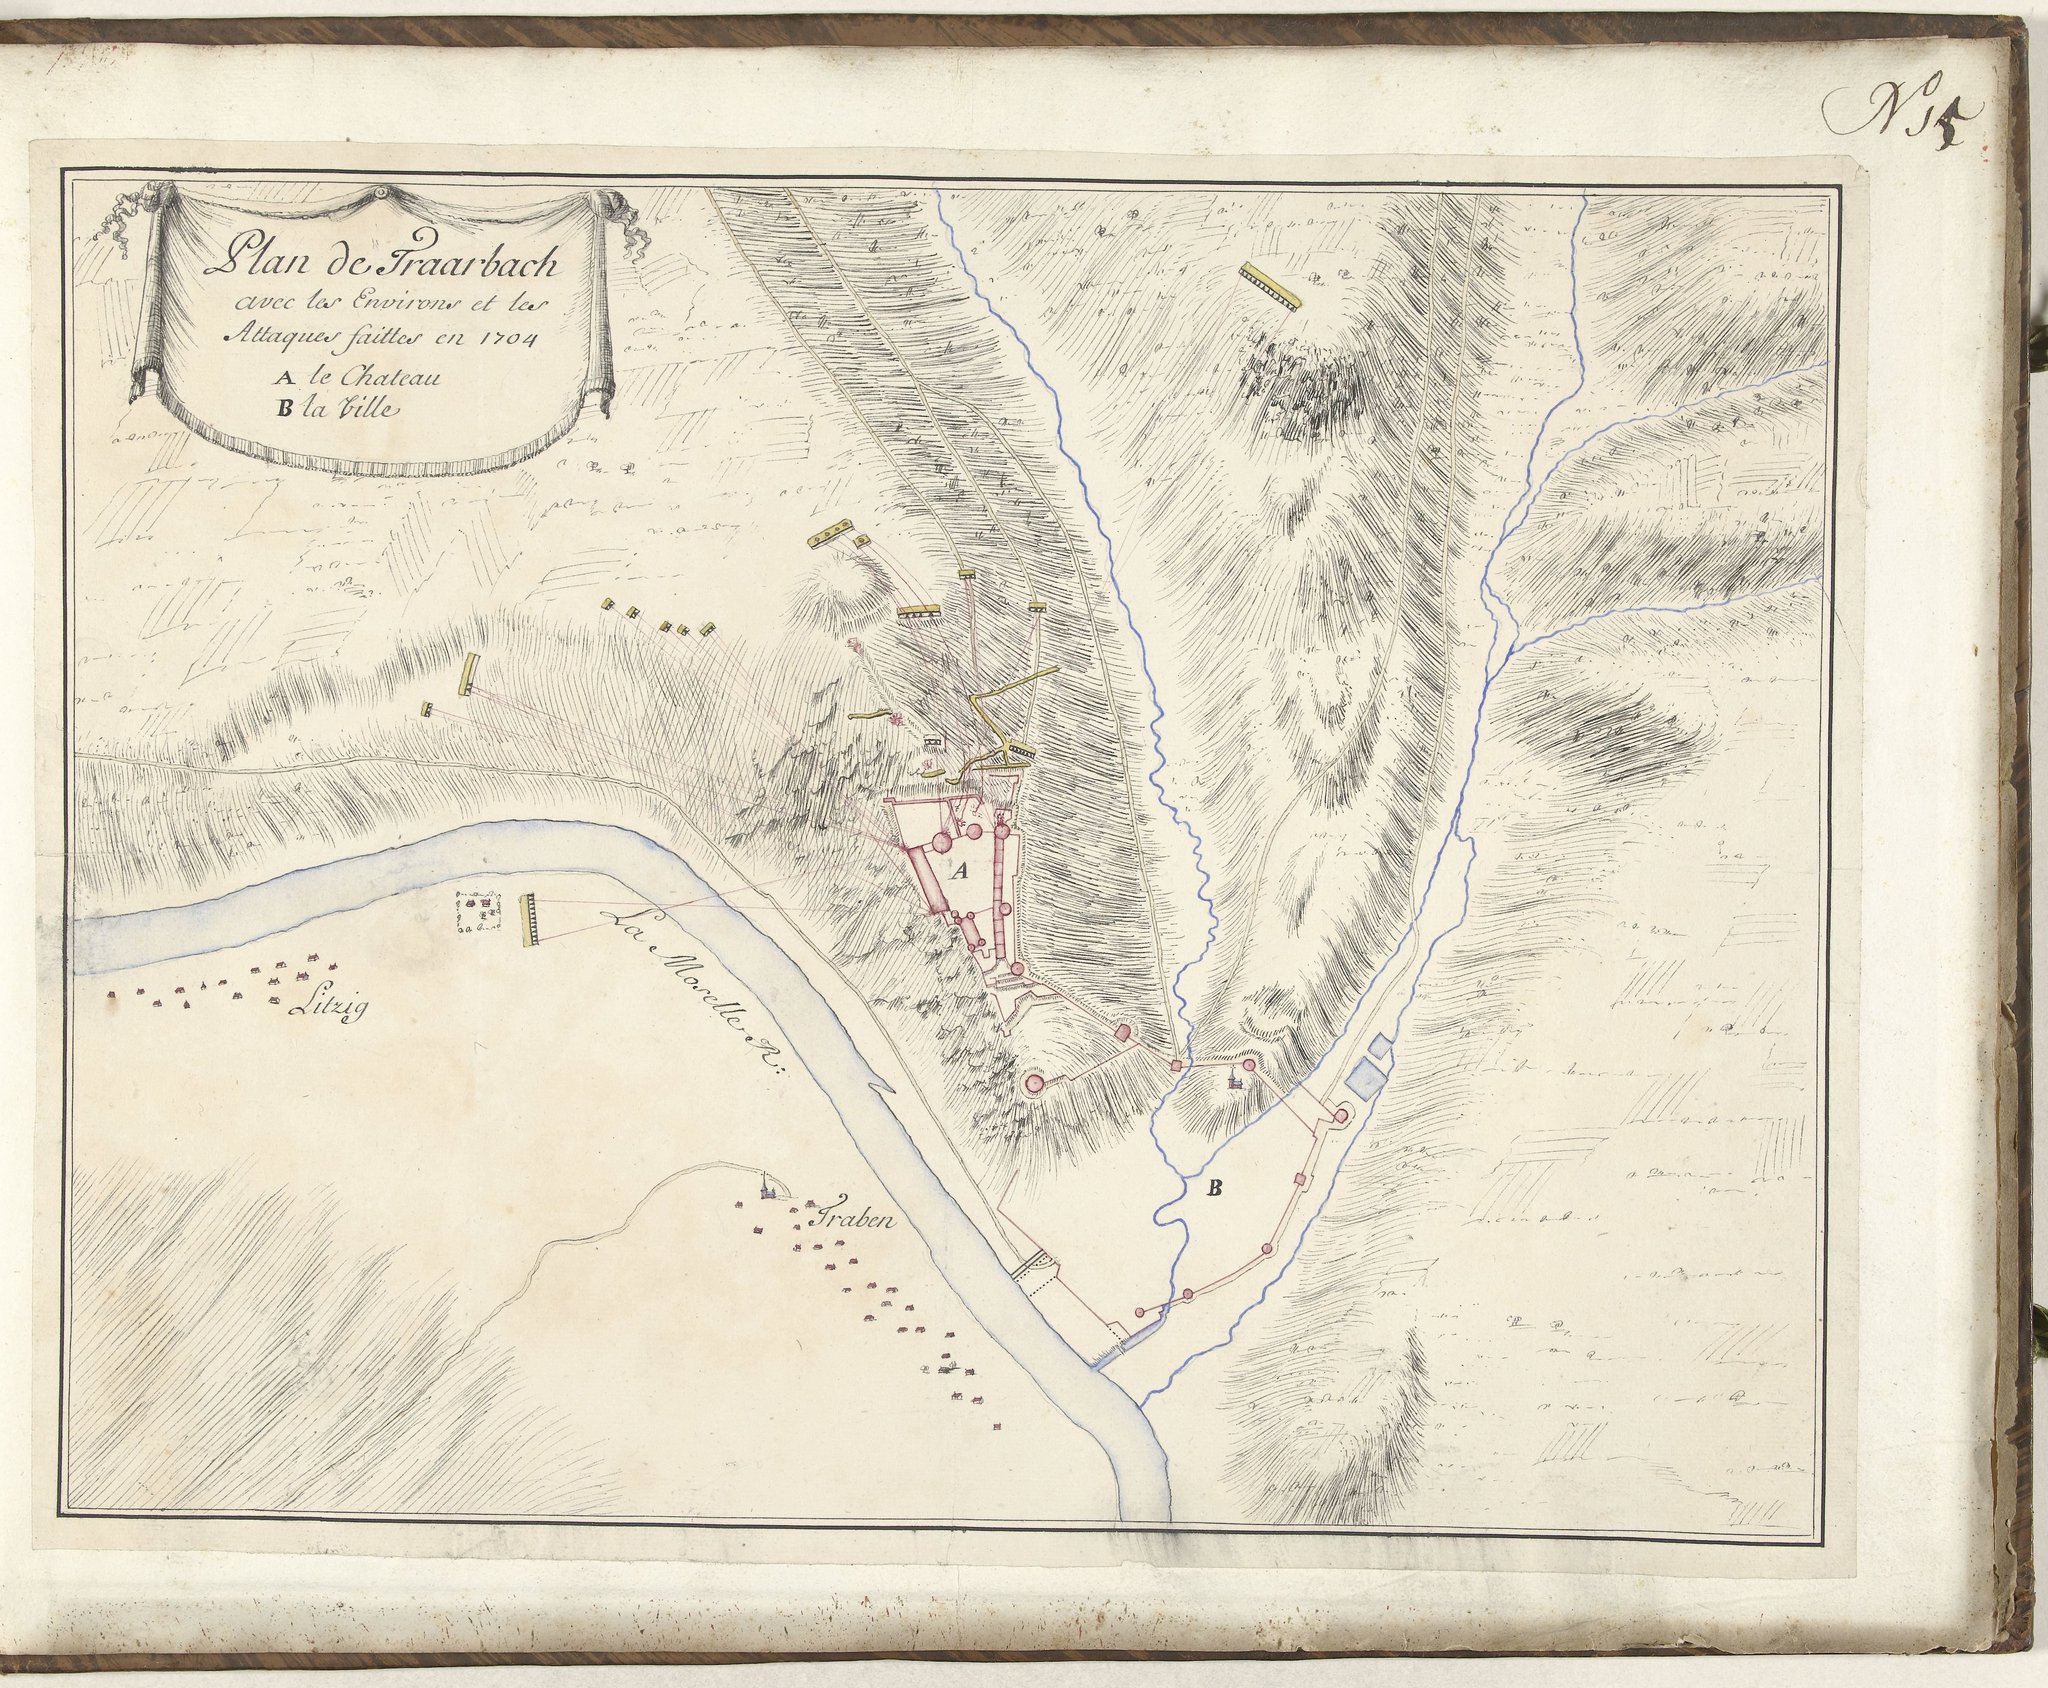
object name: map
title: Plan de Traarbach avec les Environs et les Attaques faittes en 1704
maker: samuel du ry de champdoré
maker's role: draughtsman, engineer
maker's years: 1651-1729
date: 1704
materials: paper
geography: netherlands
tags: siege, position war, maps of cities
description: Kaart met het beleg van het kasteel van Traarbach door de geallieerden vanaf 14 november, inname op 18 december 1704. Linksboven de titel en legenda A-B in het Frans. Onderdeel van een verzameling getekende plannen van versterkte plaatsen in Nederland en omringende landen ten tijde van de Spaanse Successieoorlog (deel D).